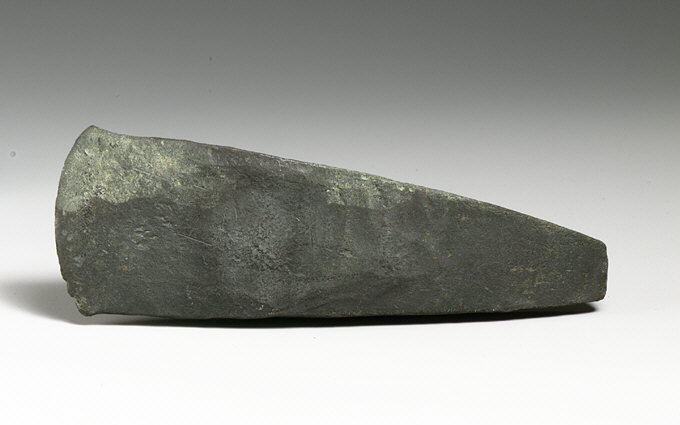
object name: axehead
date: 7000 BCE-330 CE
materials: bronze